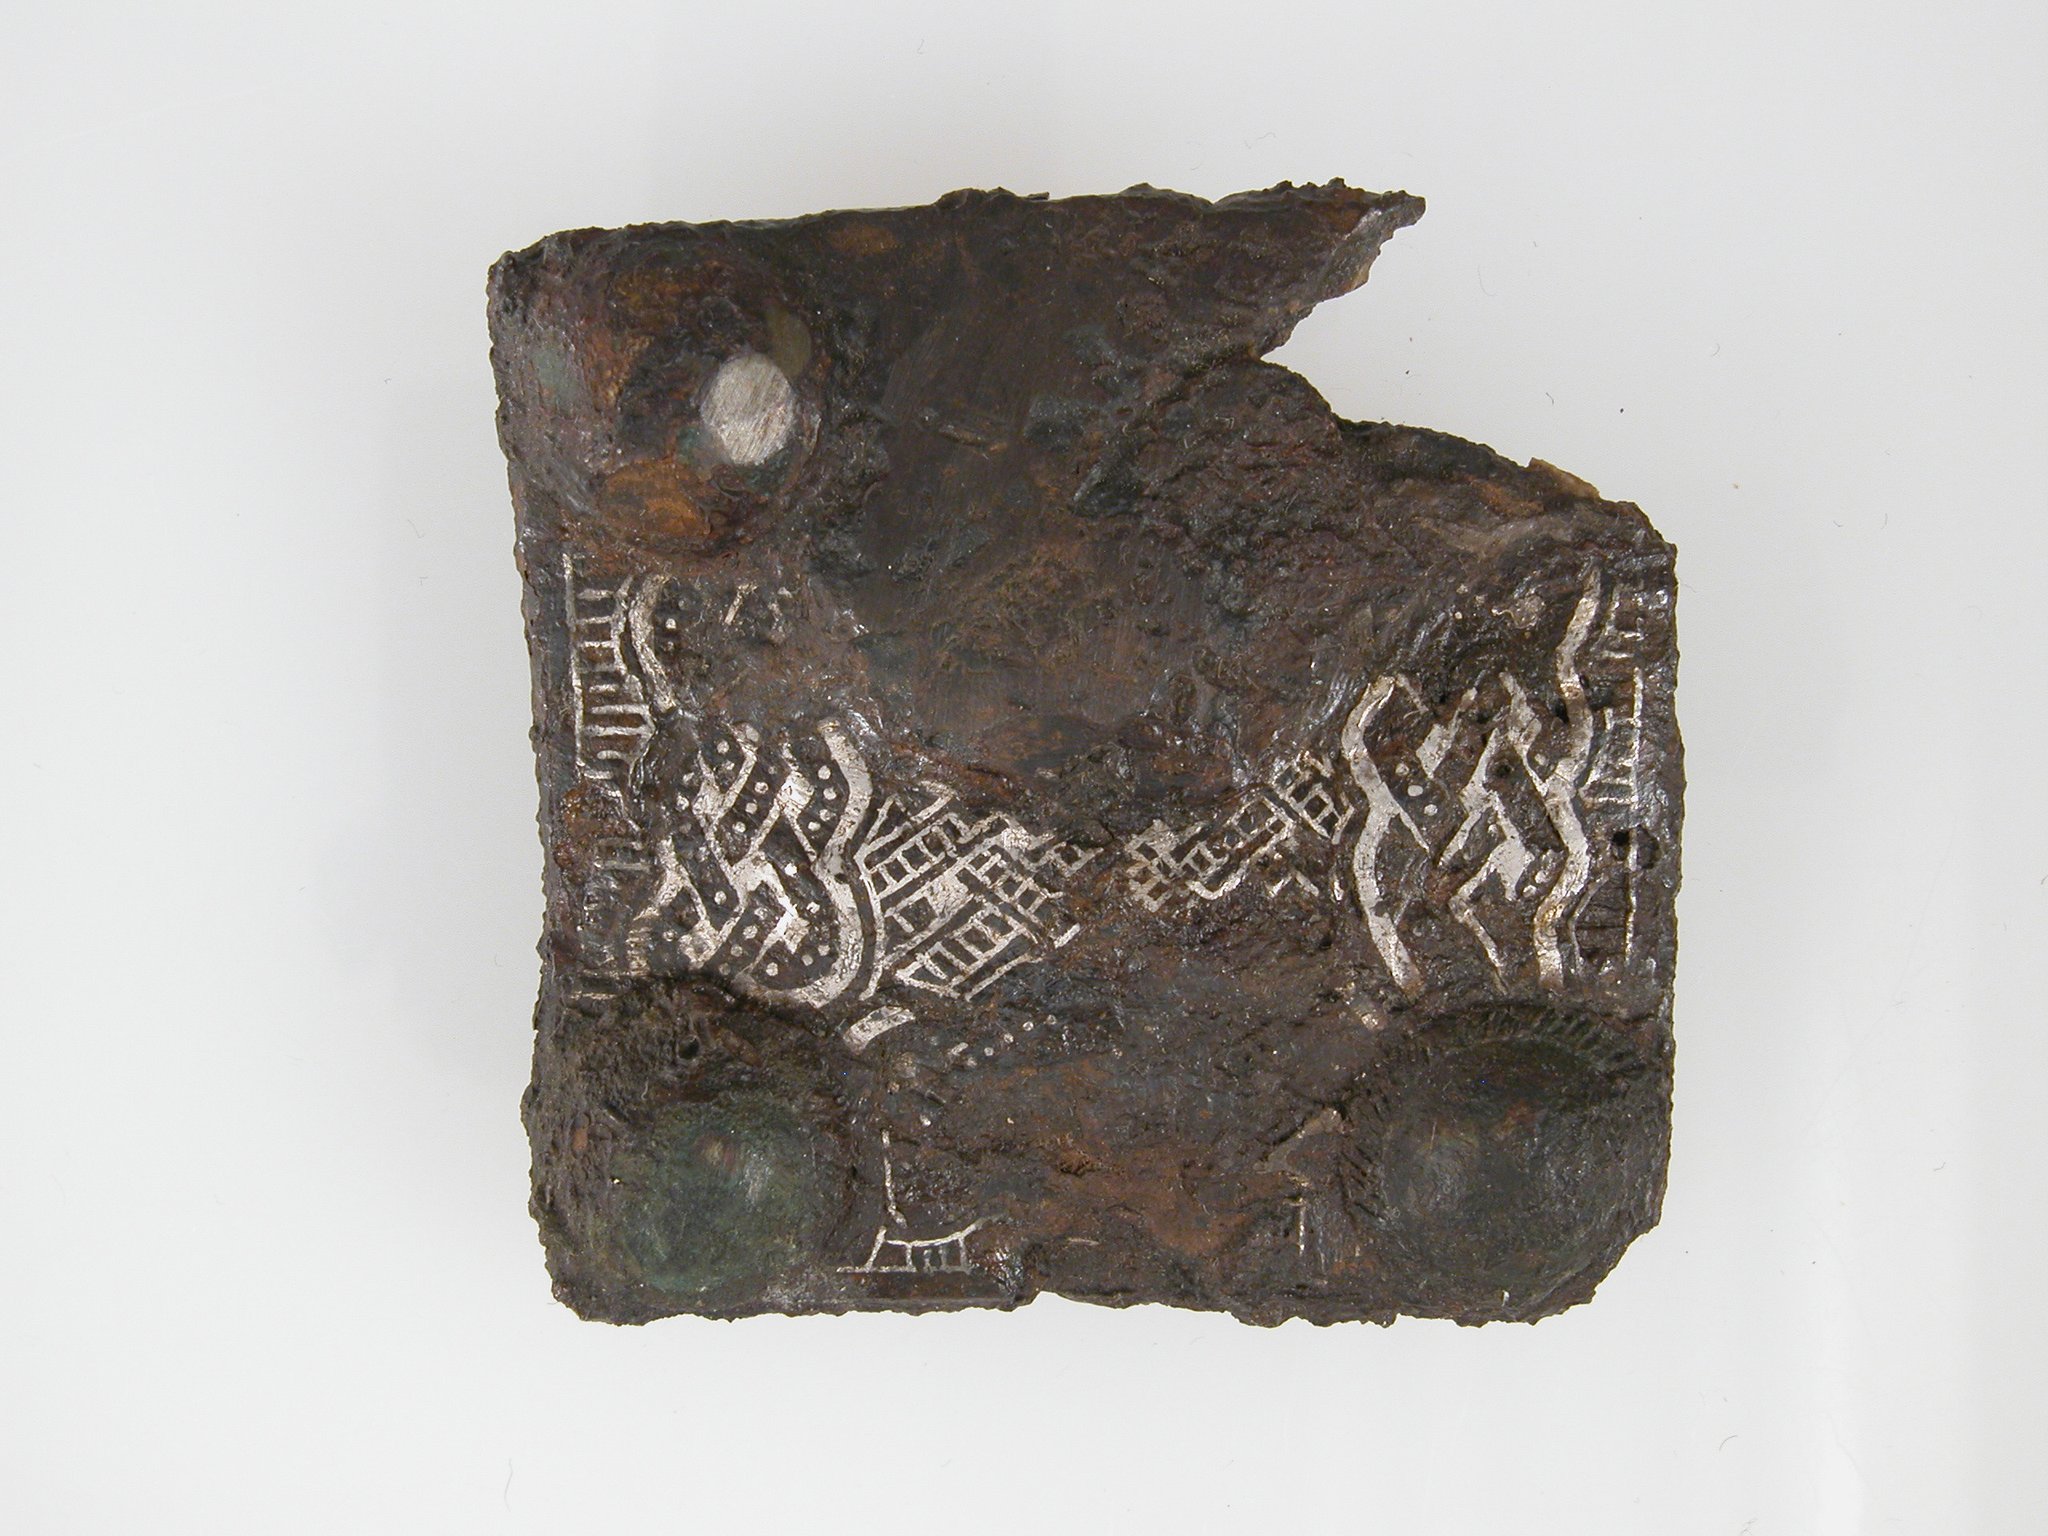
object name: belt plate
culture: frankish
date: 301-700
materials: bronze, iron, silver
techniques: inlay